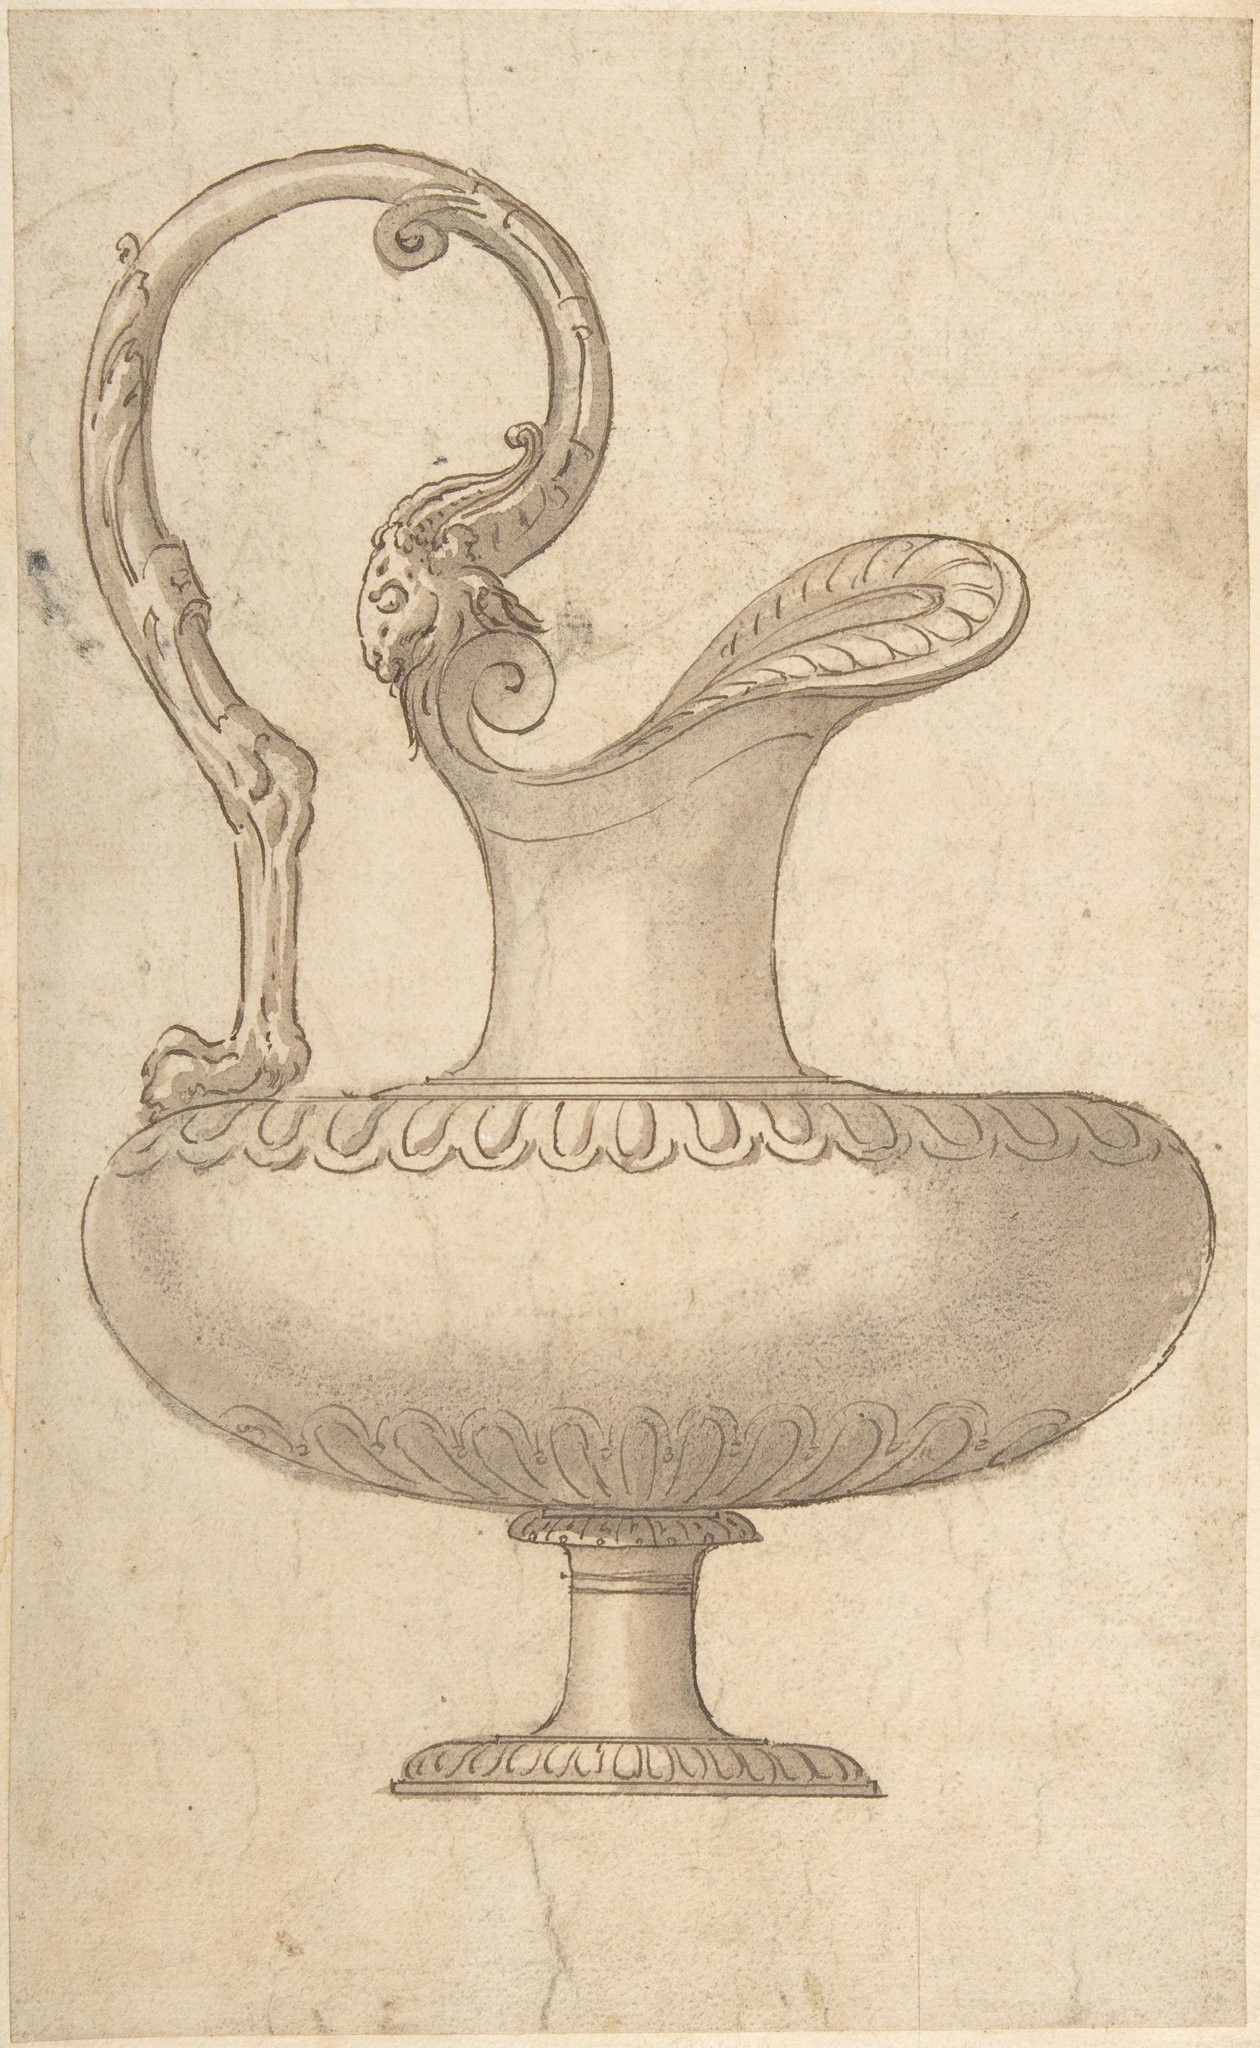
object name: drawing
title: Drawing of a Ewer in Antique Style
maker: giulio romano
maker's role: artist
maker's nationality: italian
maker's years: 1499-1546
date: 1501-1533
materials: ink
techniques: brush, pen, wash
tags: ewers